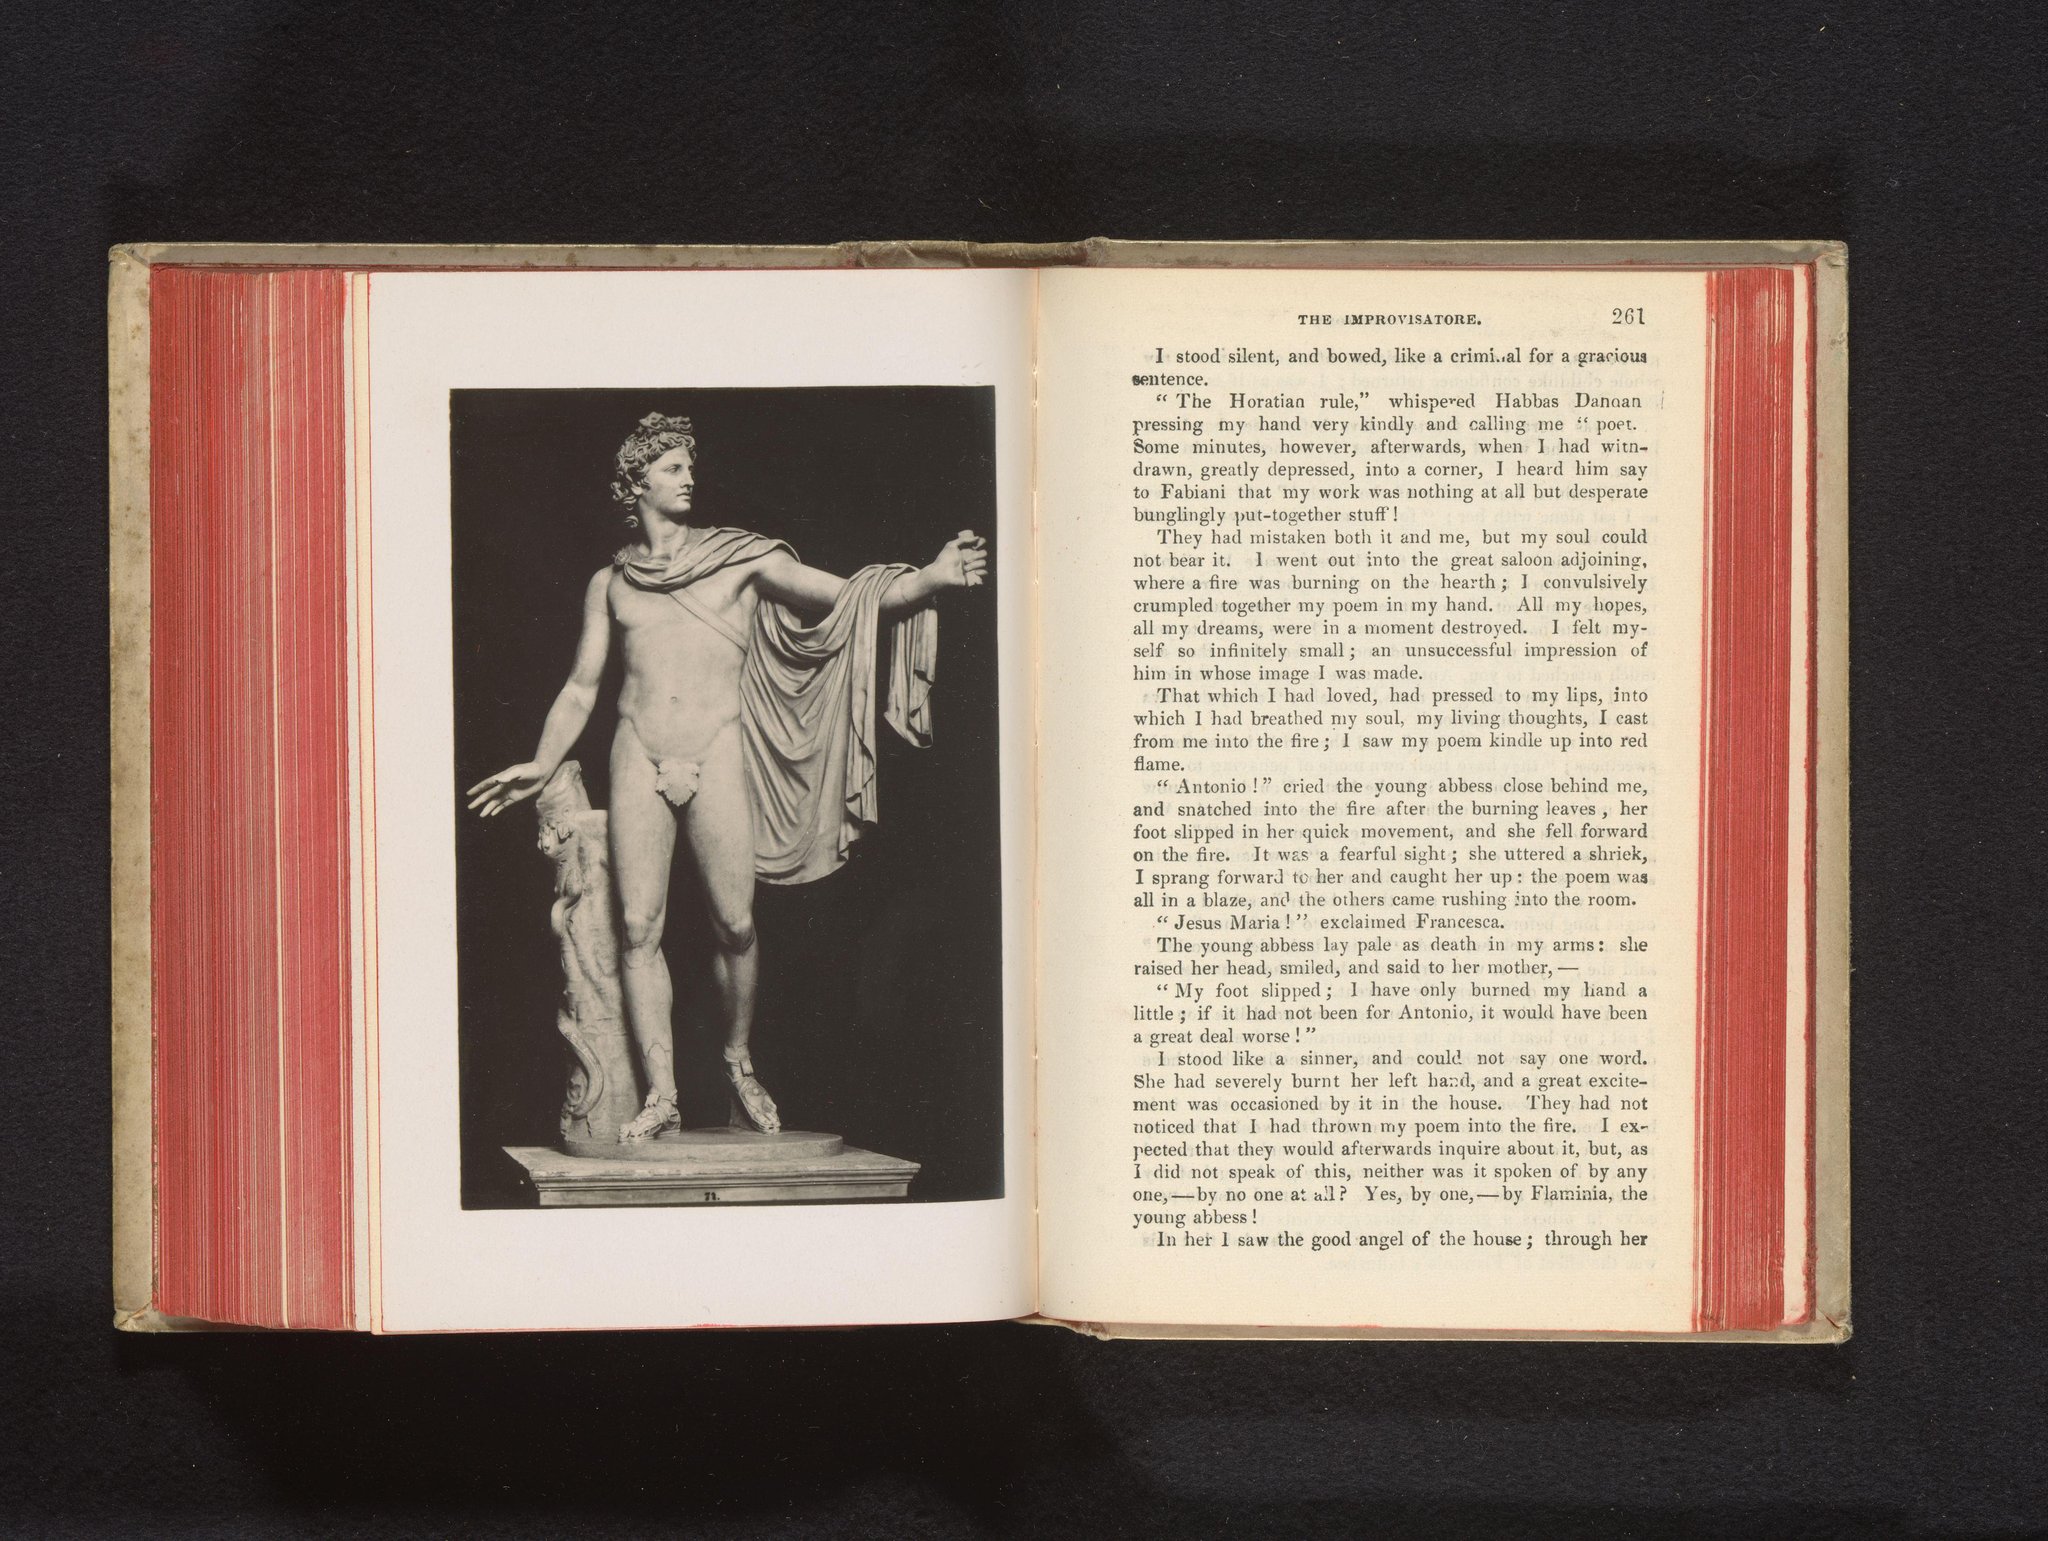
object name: page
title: Apollo van Belvedère in de Vaticaanse Musea te Vaticaanstad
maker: Anonymous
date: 1870-1880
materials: photographic support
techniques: gelatin silver print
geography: vatican museums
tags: (story of) apollo (phoebus), sculpture